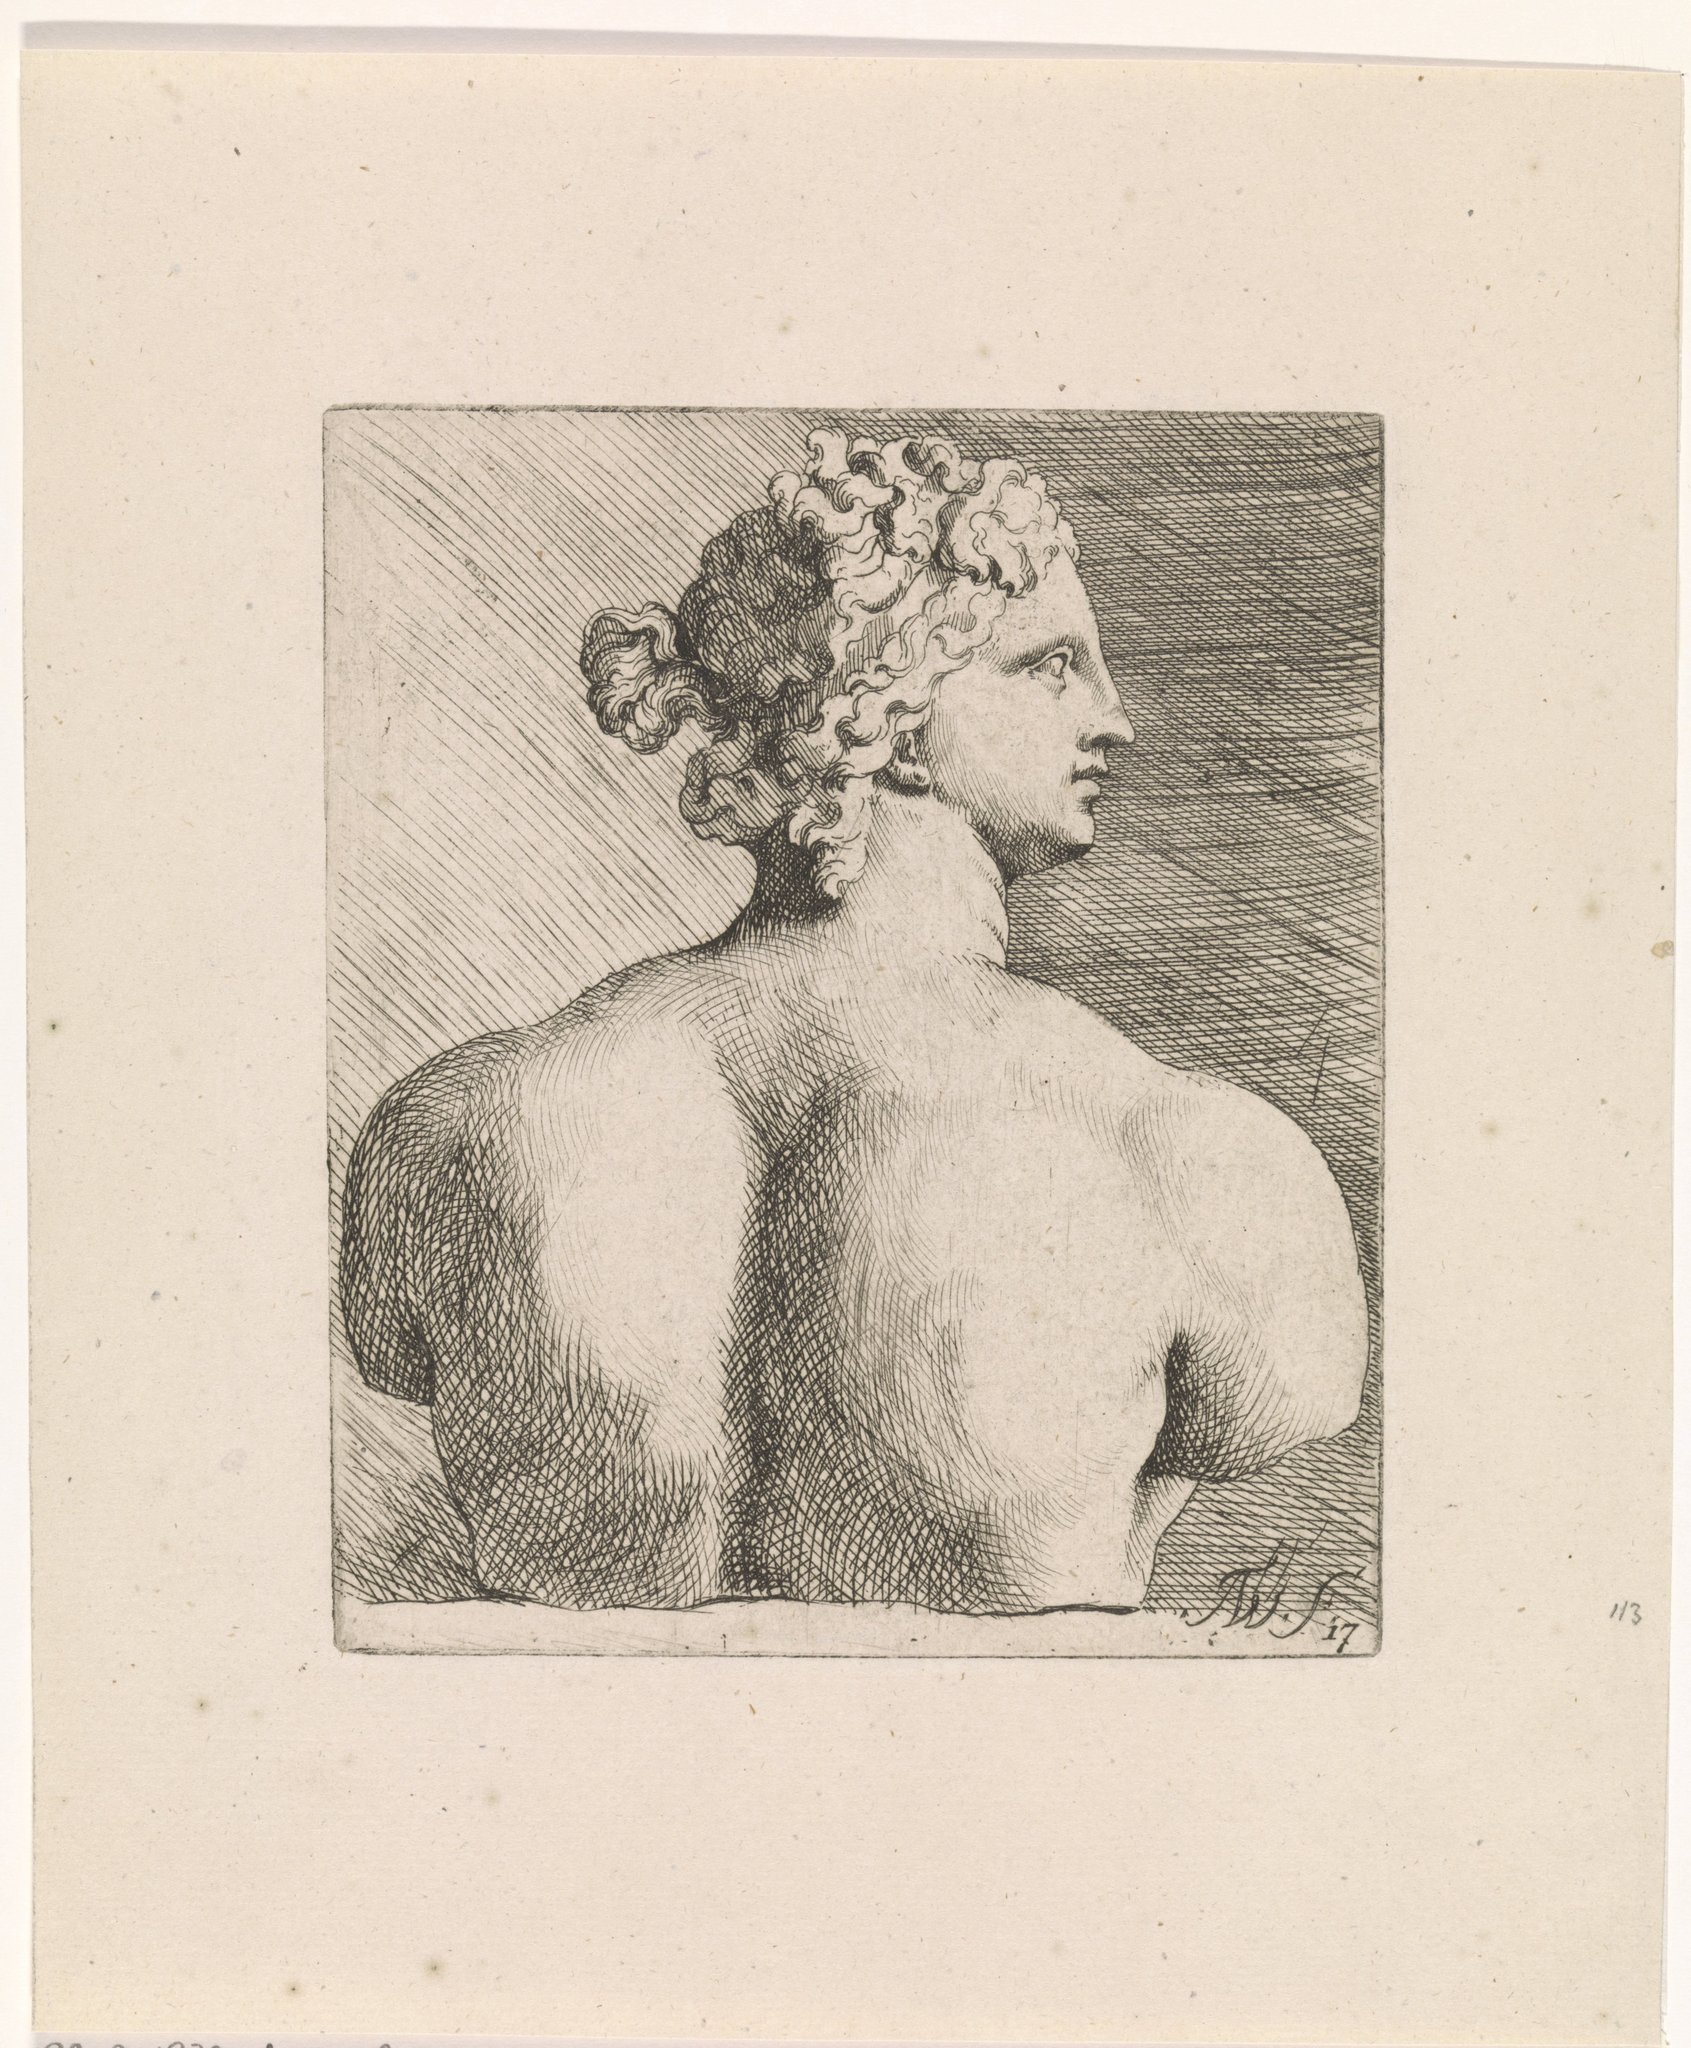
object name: print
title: Studies voor een tekeningenboek naar klassieke sculpturen en figuren van Anthony van Dyck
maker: augustinus terwesten (i)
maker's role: draughtsman, painter, print maker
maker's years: 1649-1711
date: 1672-1711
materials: paper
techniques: etching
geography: rome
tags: piece of sculpture, reproduction of a piece of sculpture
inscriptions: collector's mark: Lugt 2228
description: Kopie van de klassieke sculptuur van Venus de' Medici, op de rug gezien, het hoofd naar rechts.